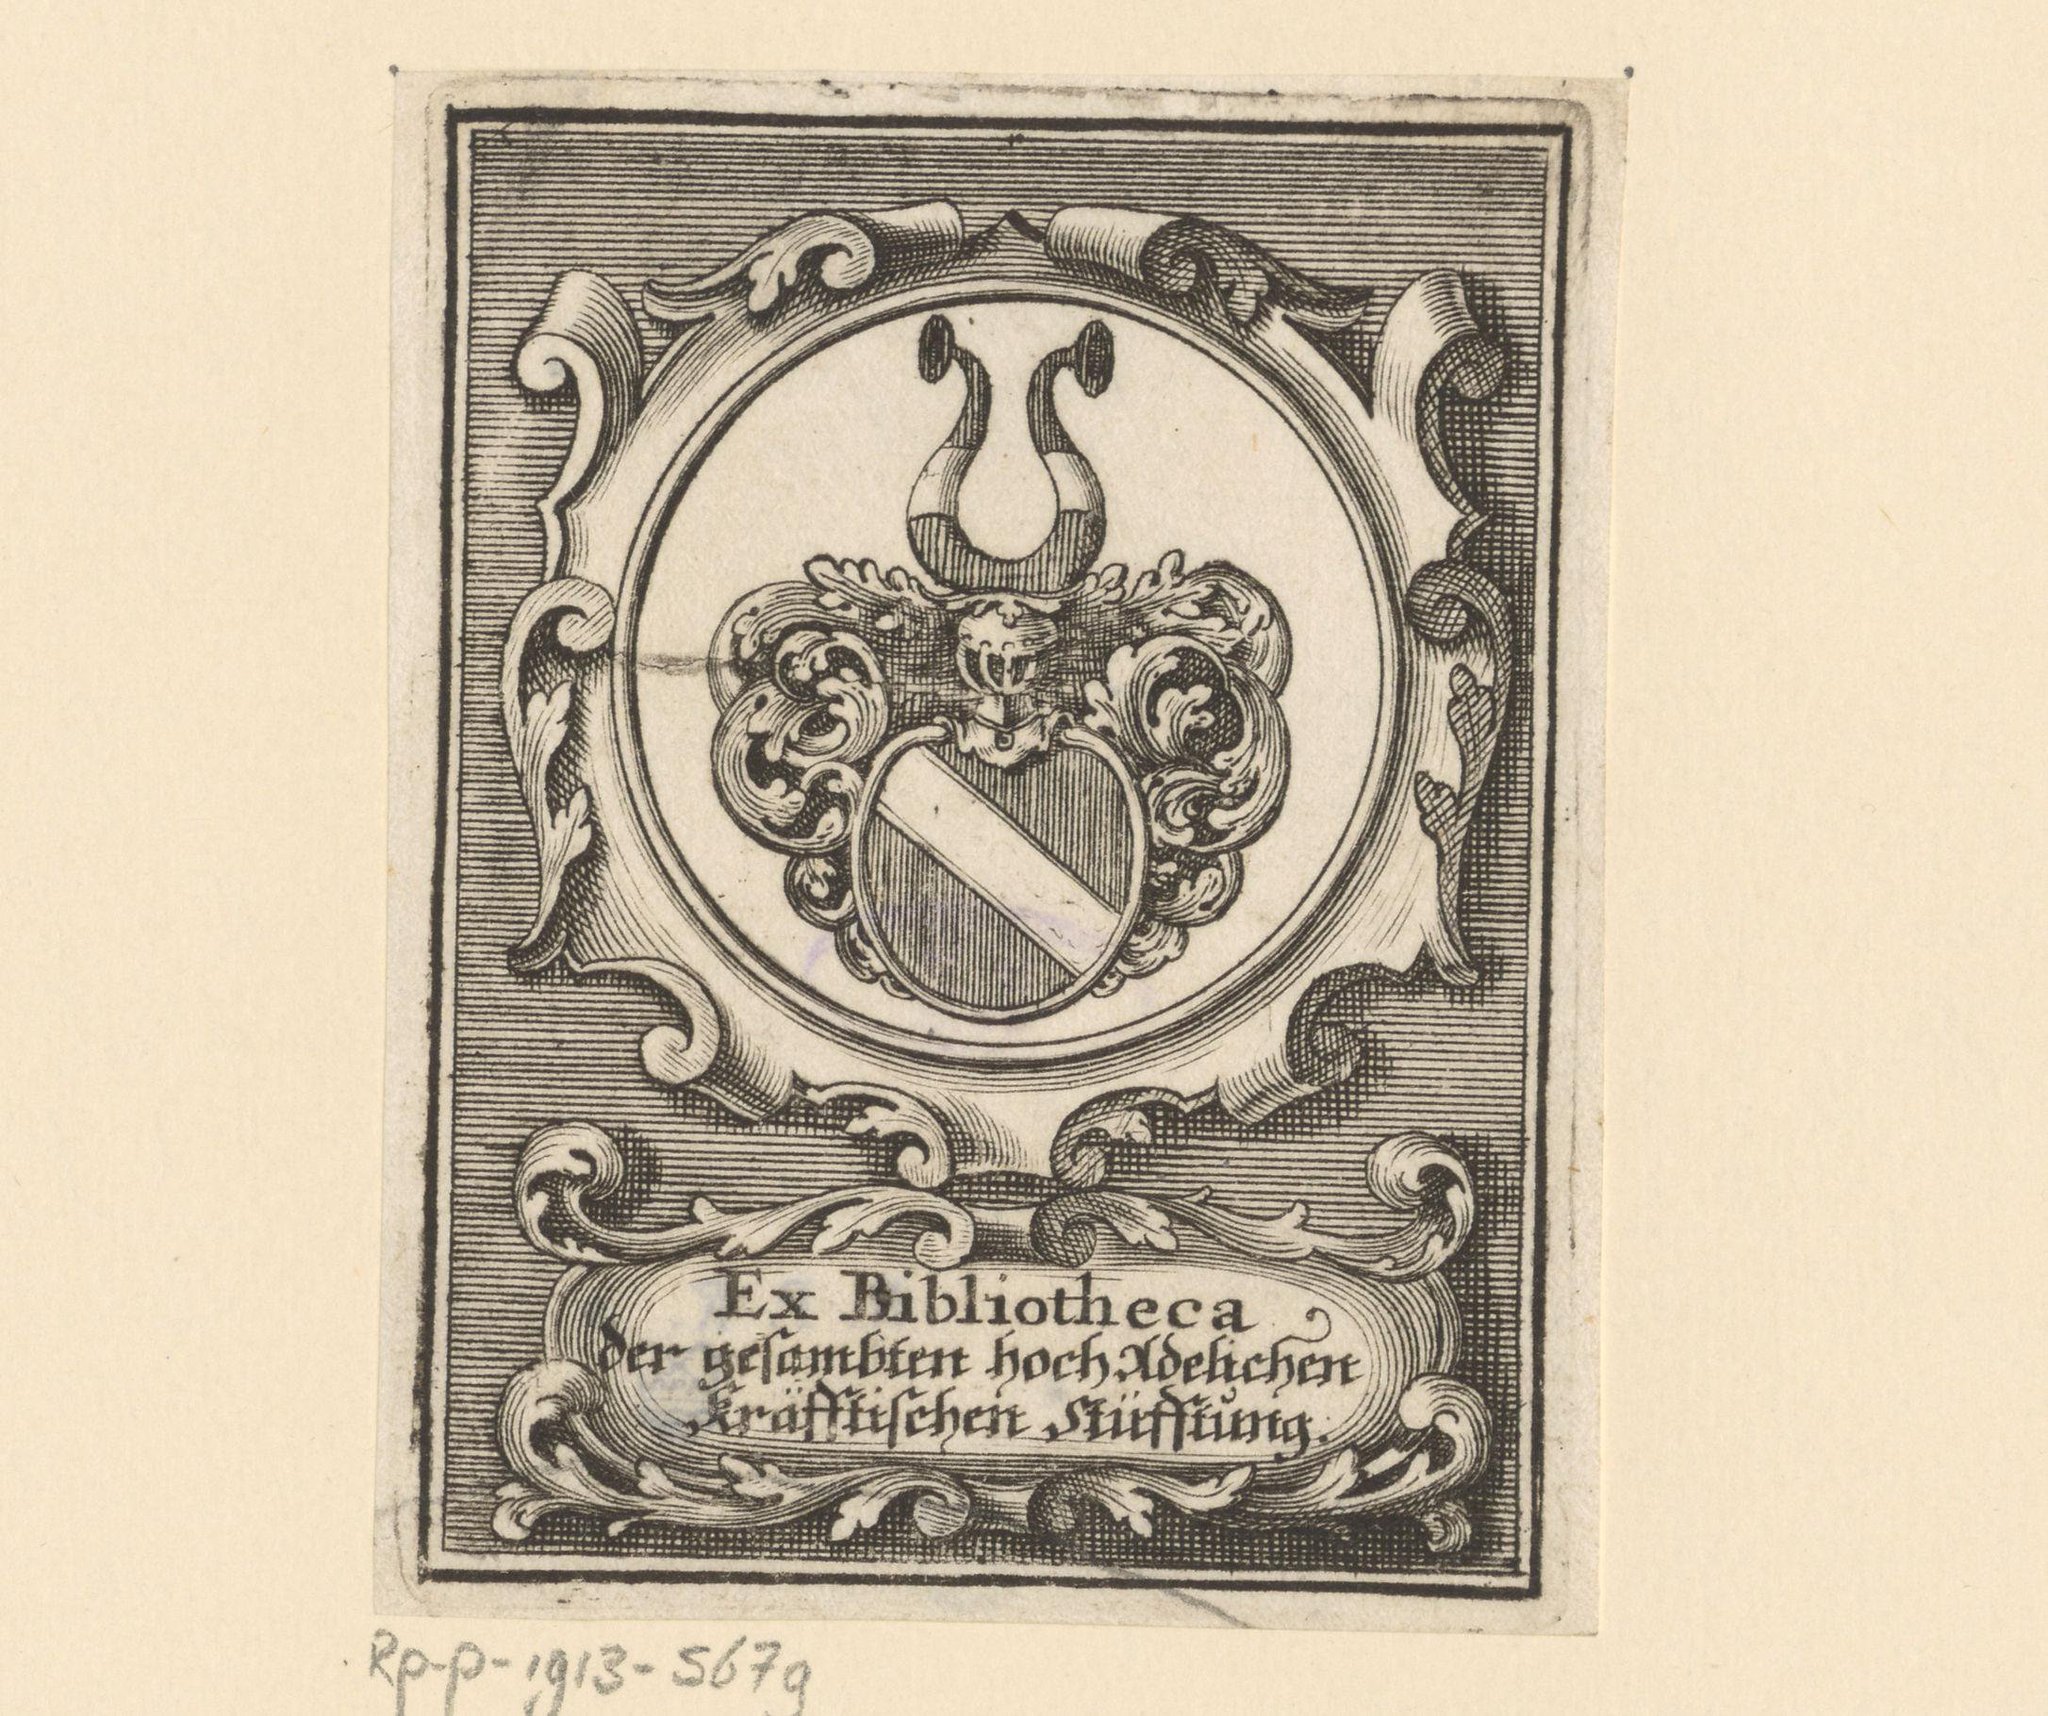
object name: bookplate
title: Ex libris van der gesambten hoch Adelichen Kräfftischen Stüffting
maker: Anonymous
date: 1700-1799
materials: paper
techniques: engraving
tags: armorial bearing, heraldry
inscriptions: collector's mark: Lugt 2760, collector's mark: Lugt 2233, collector's mark